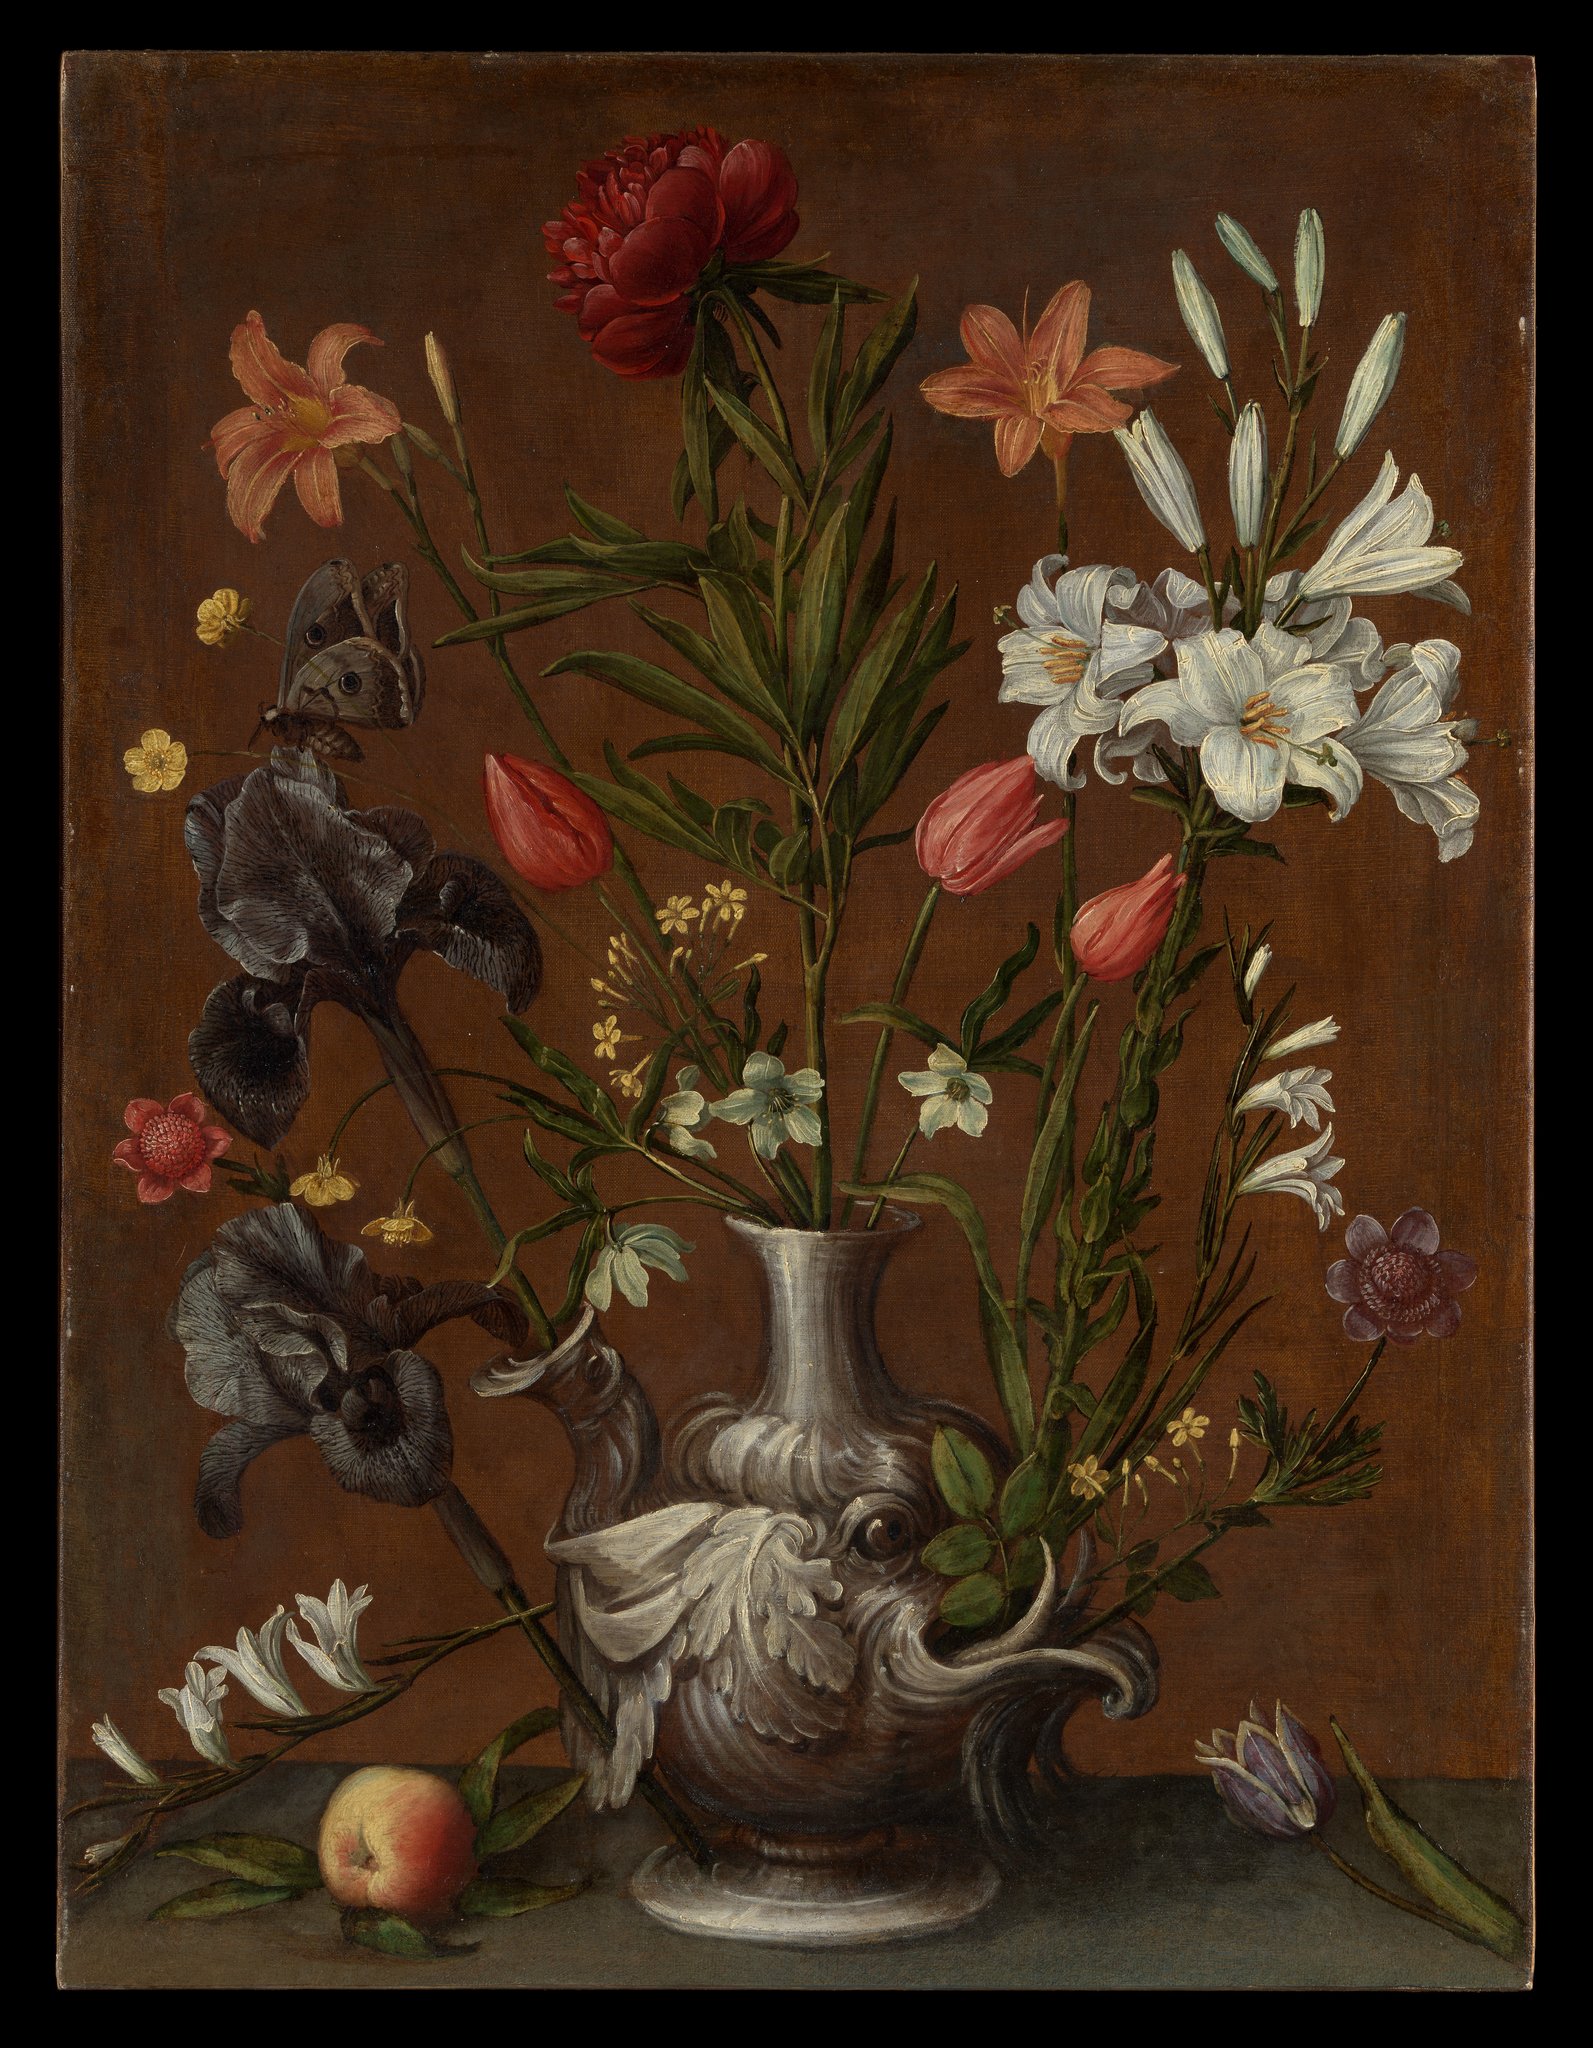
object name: painting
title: Flowers in a Grotesque Vase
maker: orsola maddalena caccia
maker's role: artist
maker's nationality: italian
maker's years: 1596-1676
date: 1635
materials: canvas, oil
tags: peaches,flowers,tulips,still life,vases